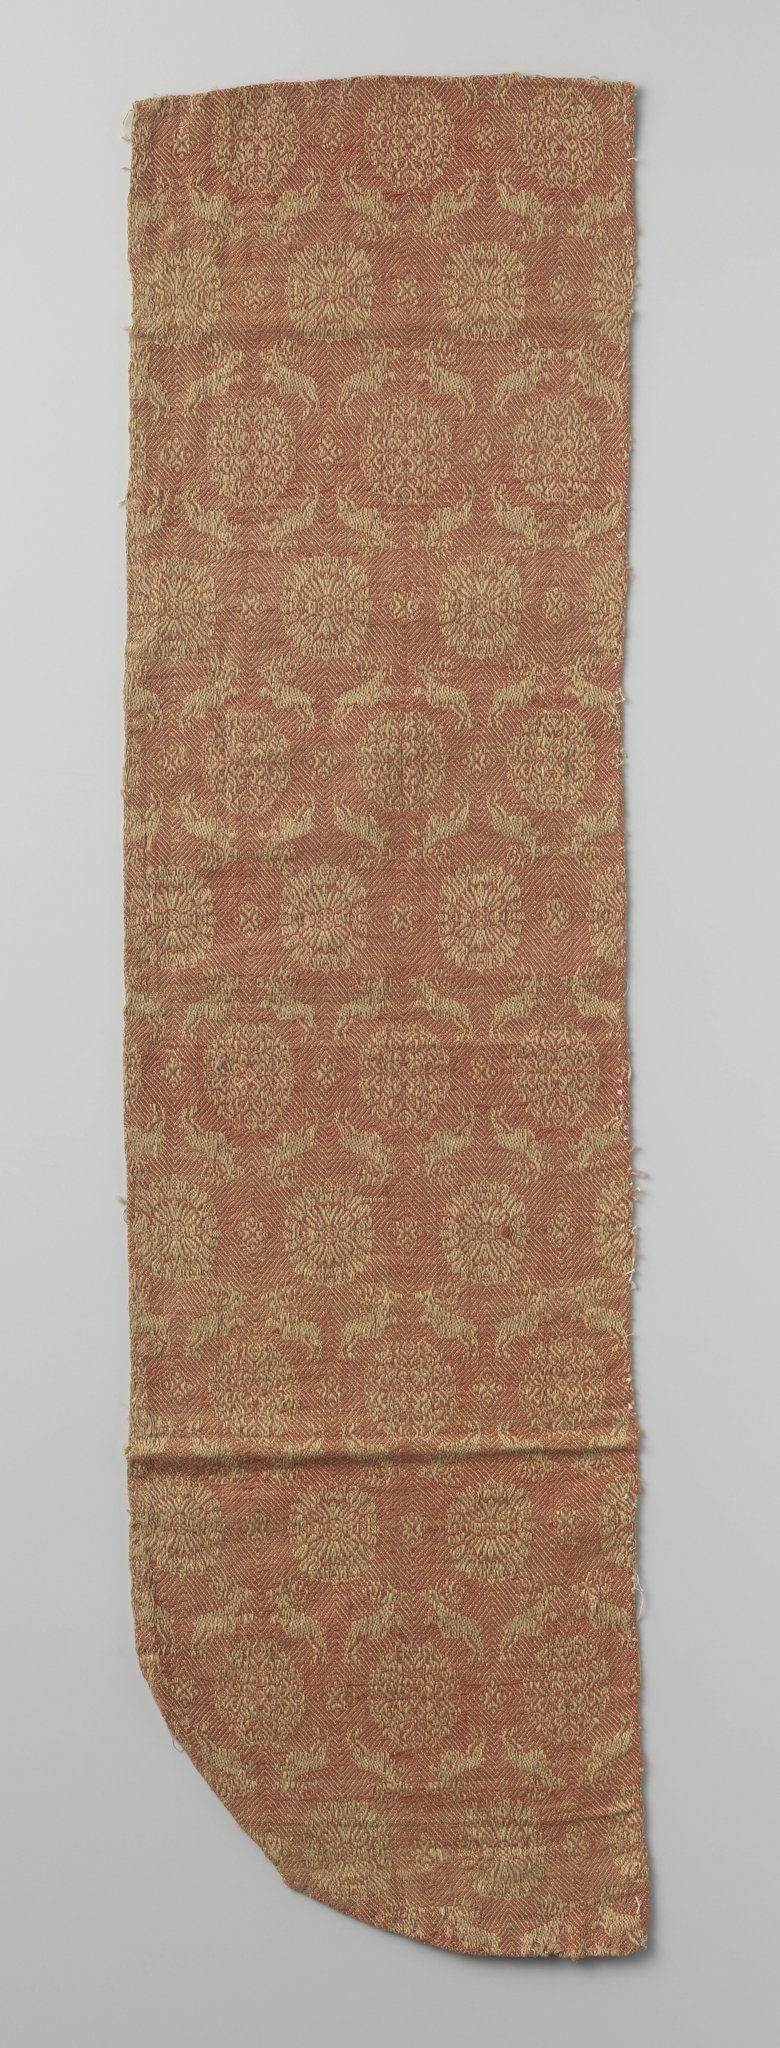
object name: woven material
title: Fragment wollen samiet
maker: Anonymous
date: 1500-1599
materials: linen, wool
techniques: samite, weave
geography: germany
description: Fragment wollen samiet met patroon van rozetten en springende herten.